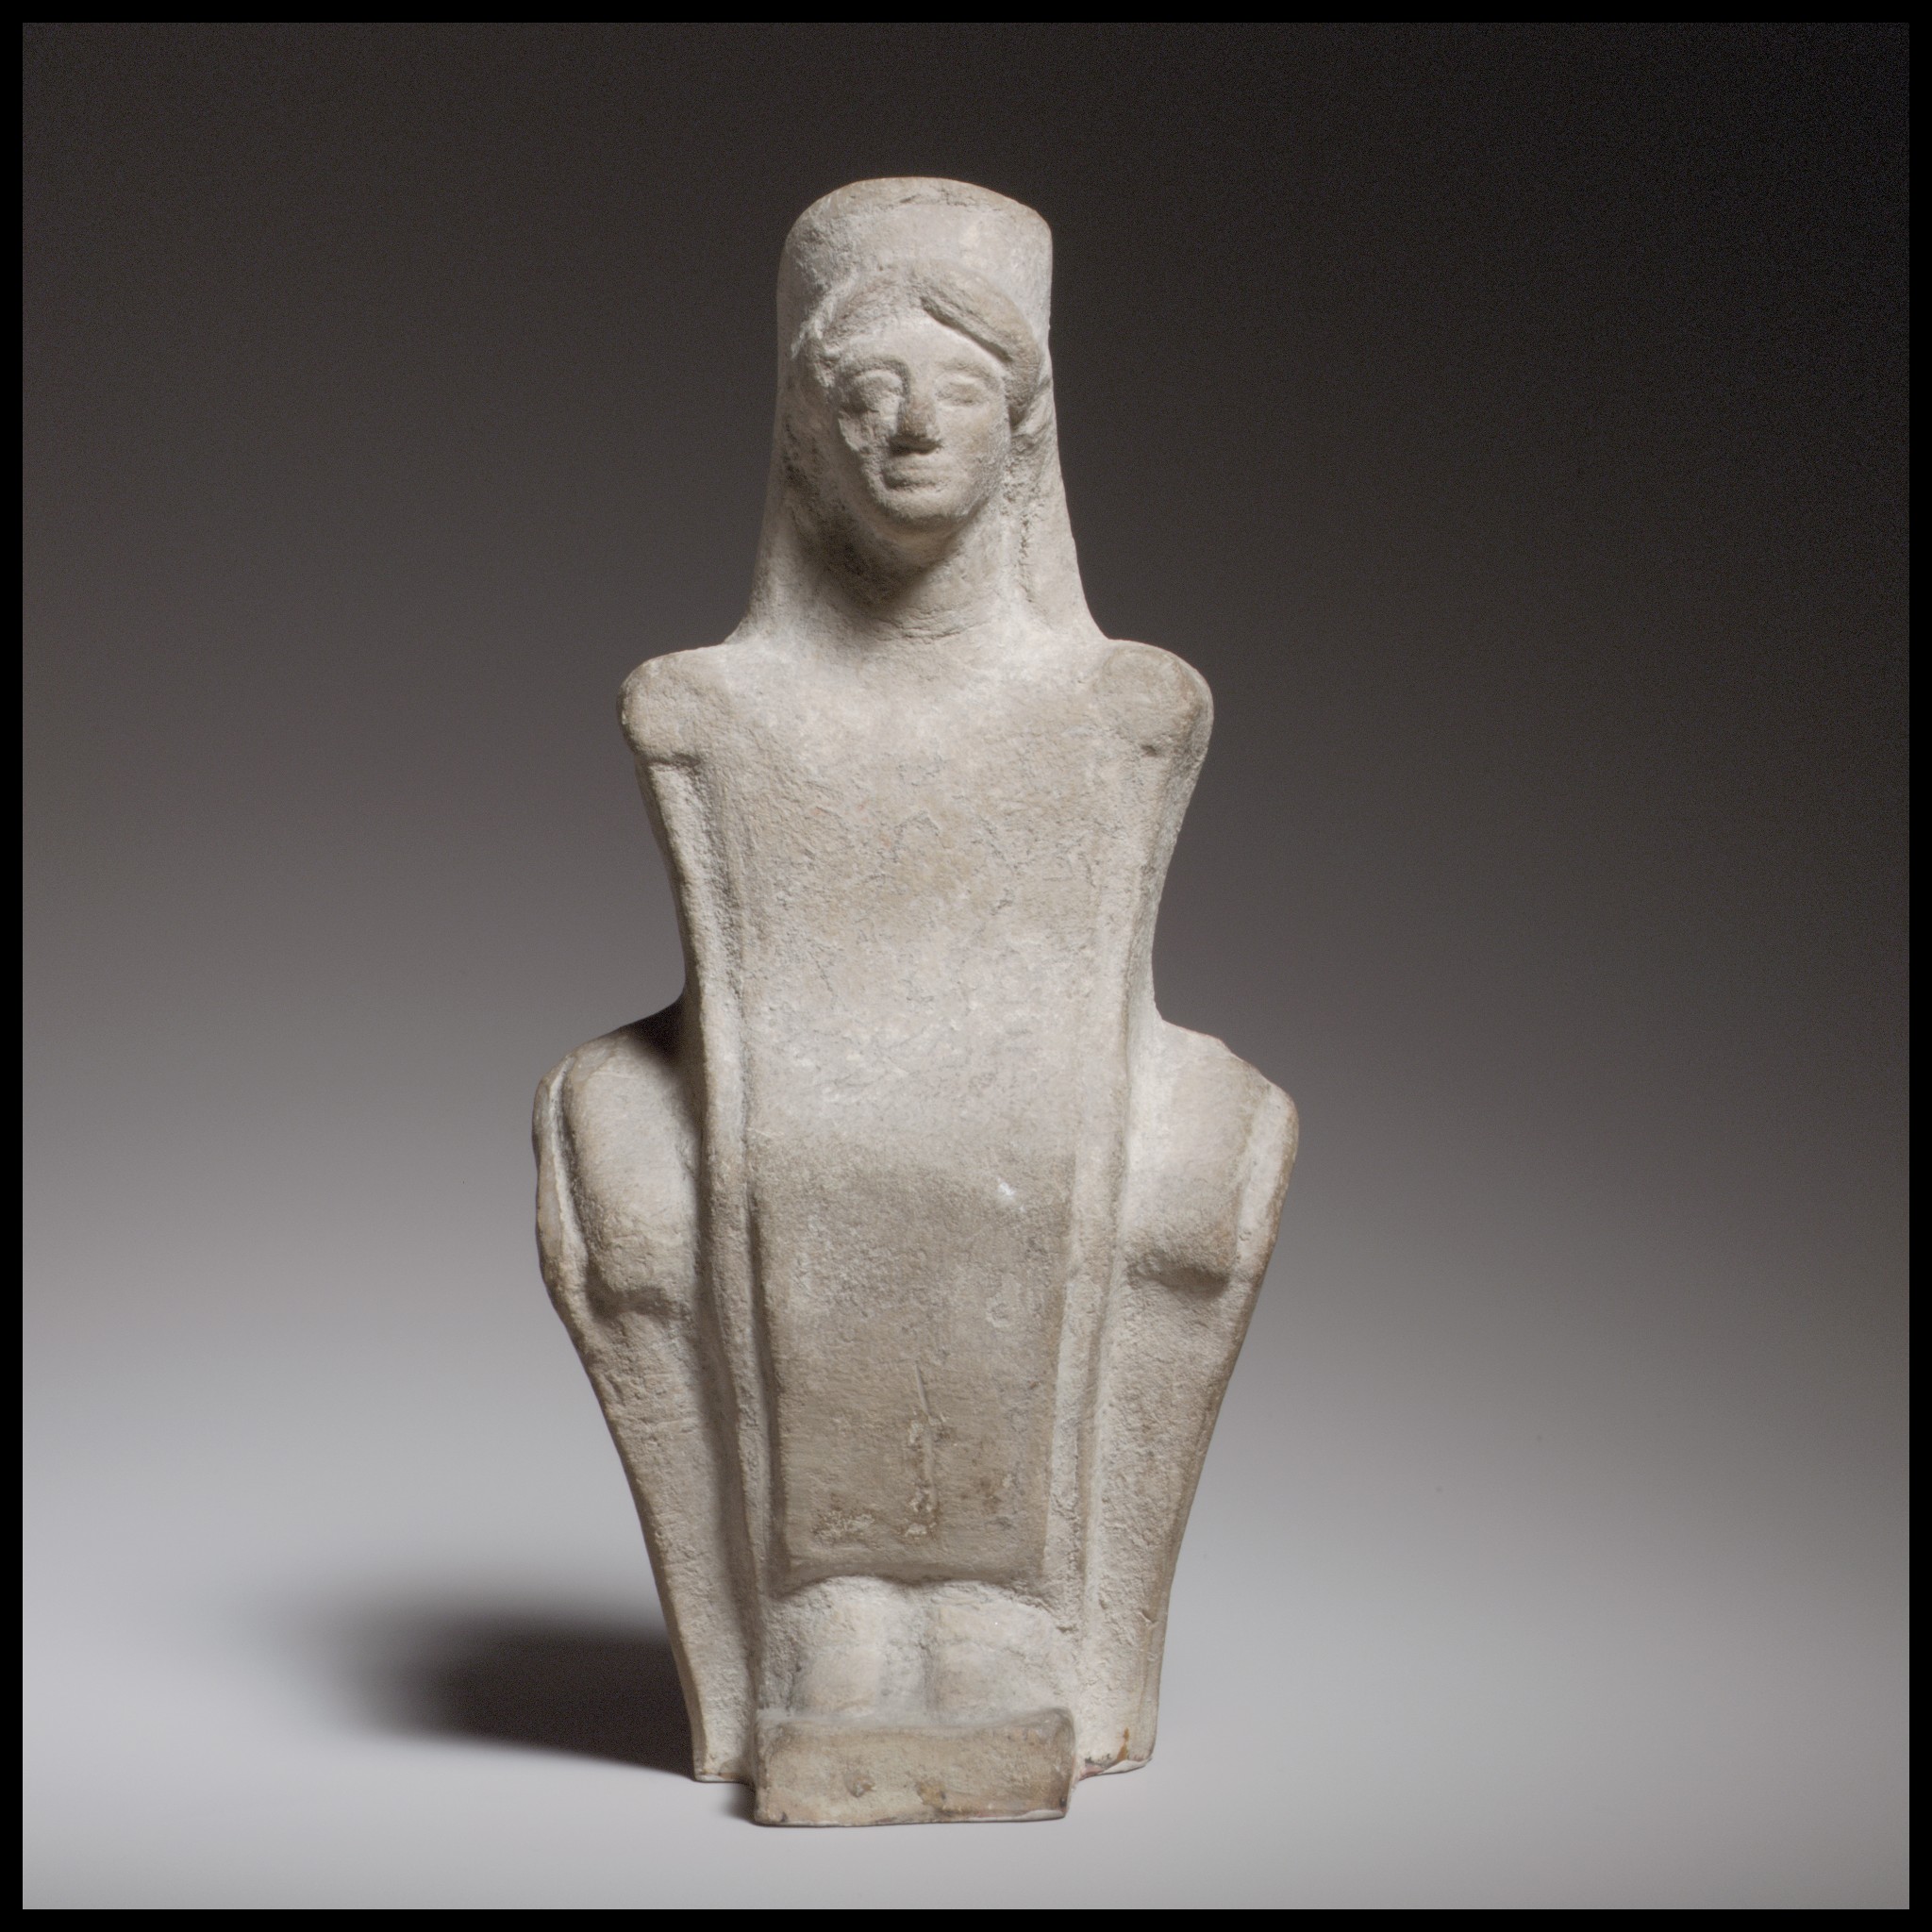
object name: statuette of a woman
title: Seated female figurine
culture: cypriot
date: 600-480 BCE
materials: terracotta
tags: women